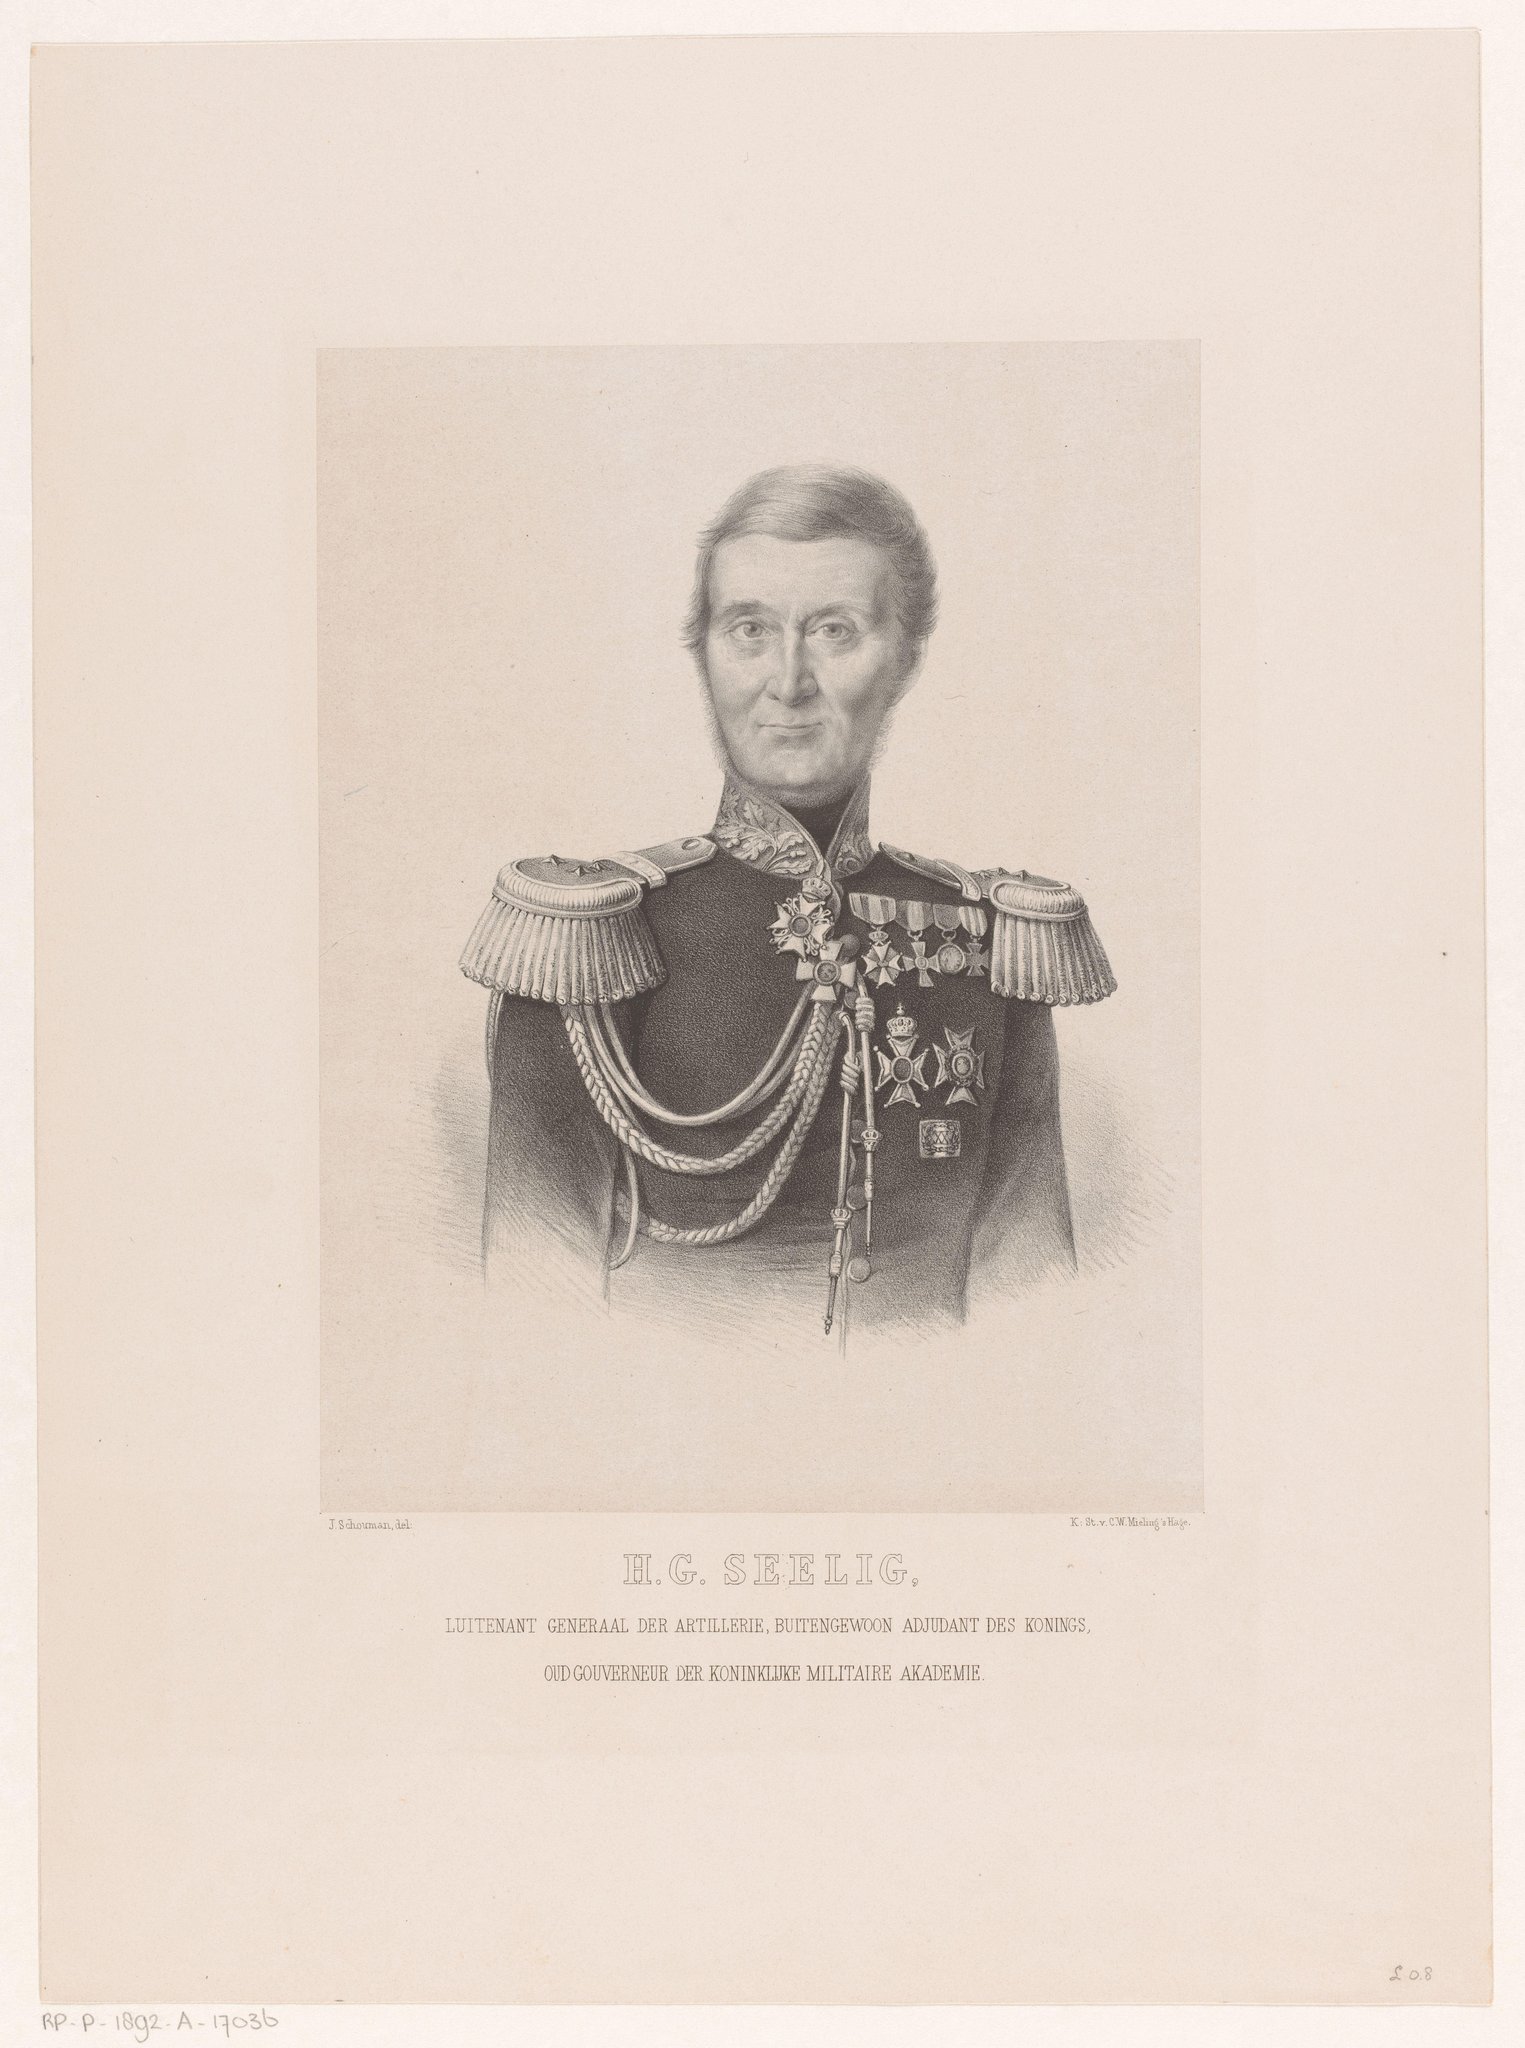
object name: print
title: H.G. Seelig, Luitenant generaal der artillerie, buitengewoon adjudant des konings (...)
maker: izaak schouman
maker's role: draughtsman, painter, print maker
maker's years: 1801-1878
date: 1852-1865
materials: paper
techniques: lithograph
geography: the hague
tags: historical persons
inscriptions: collector's mark: Lugt 2228